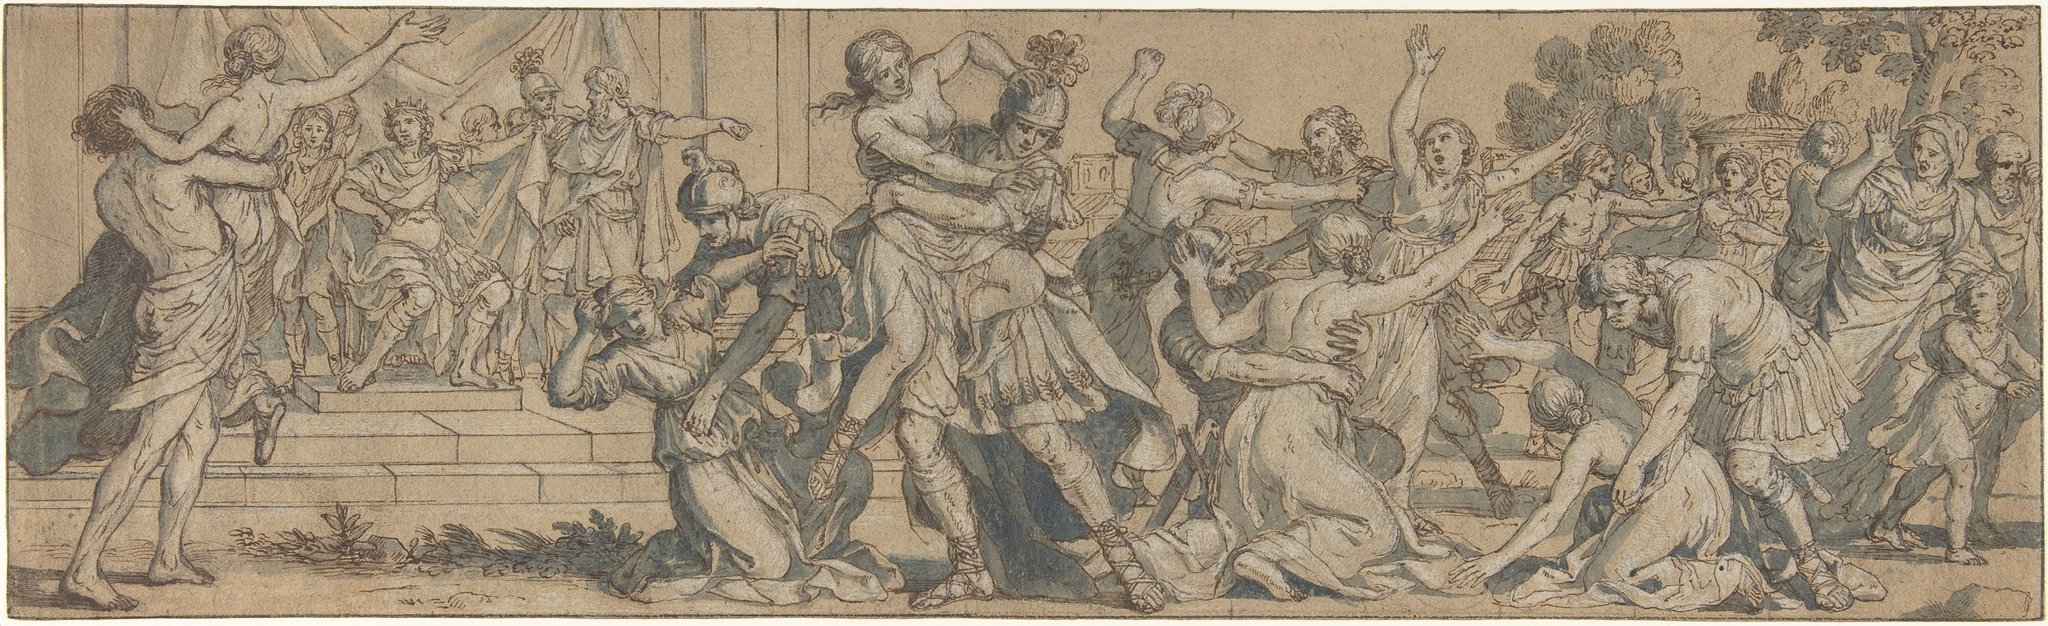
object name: drawing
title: The Rape of the Sabines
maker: giacinto gimignani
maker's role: artist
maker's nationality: italian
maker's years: 1606-1681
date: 1606-1681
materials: chalk, ink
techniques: brush, highlighting, pen, wash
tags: suffering,men,women